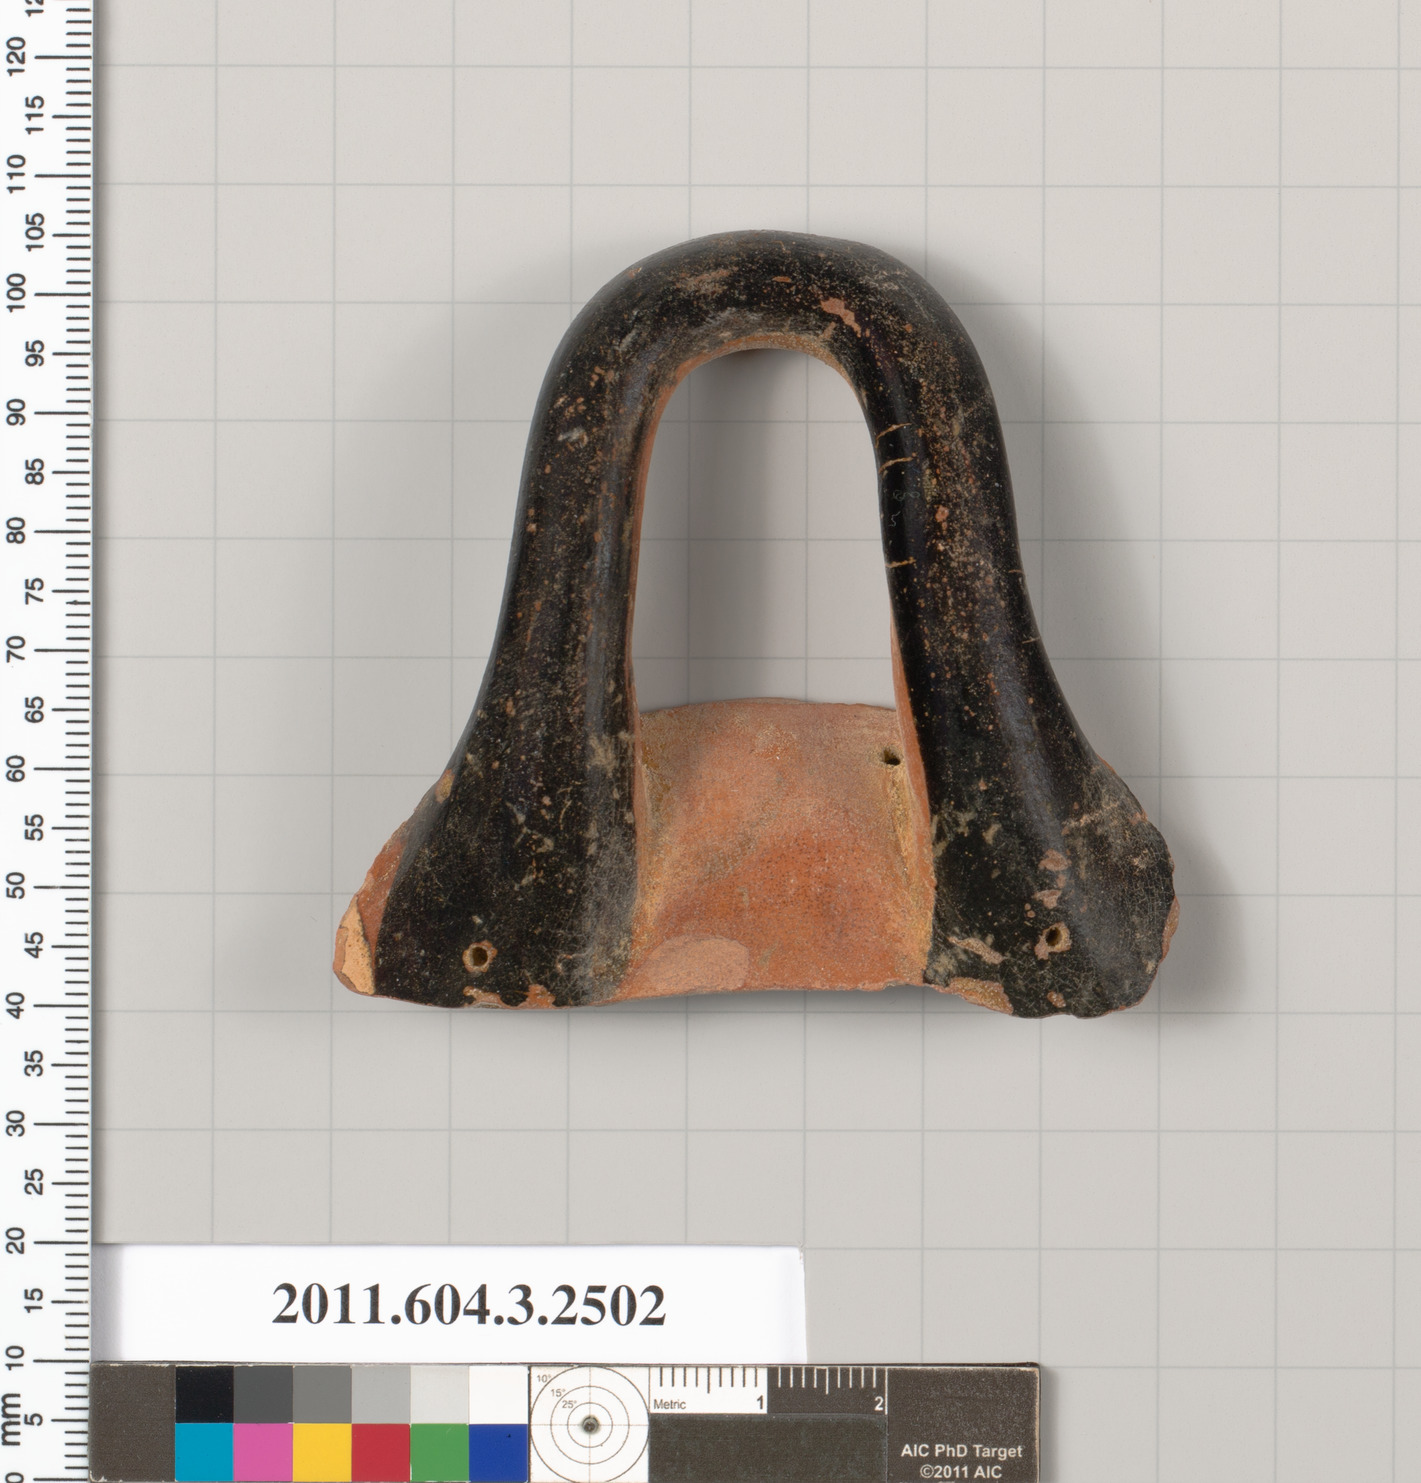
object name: kylix fragment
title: Terracotta fragment of a kylix (drinking cup)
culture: greek, attic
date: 600-401 BCE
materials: terracotta